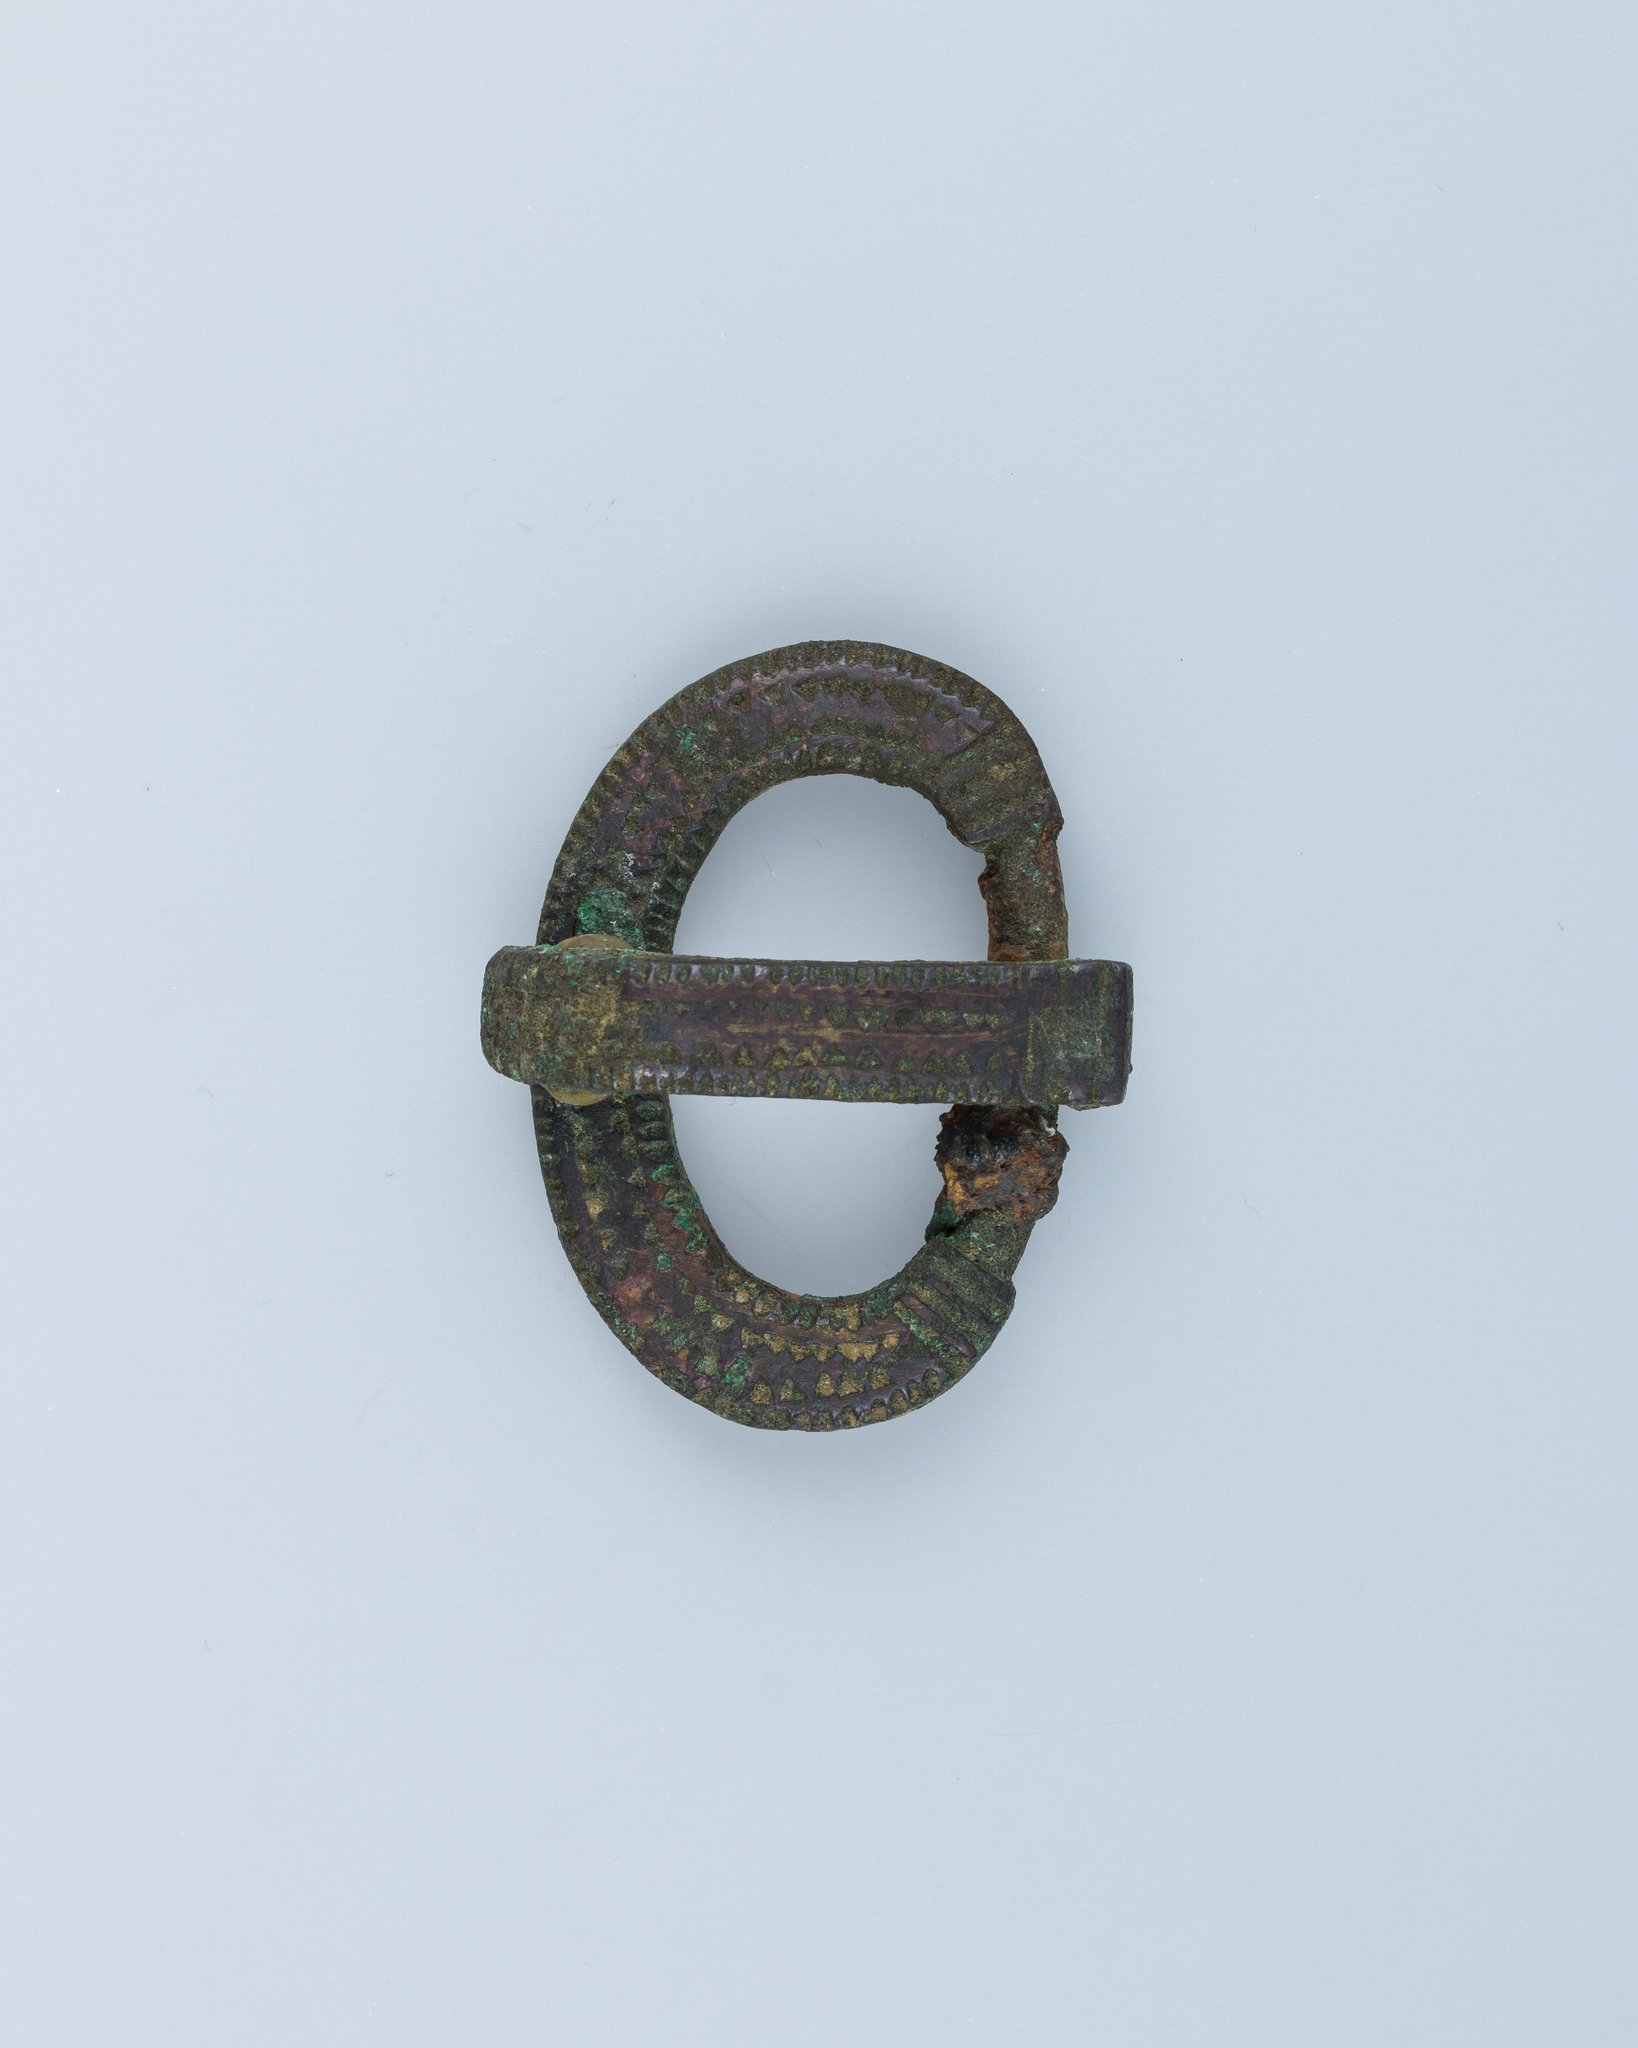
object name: buckle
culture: ibero-roman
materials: bronze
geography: spain or portugal